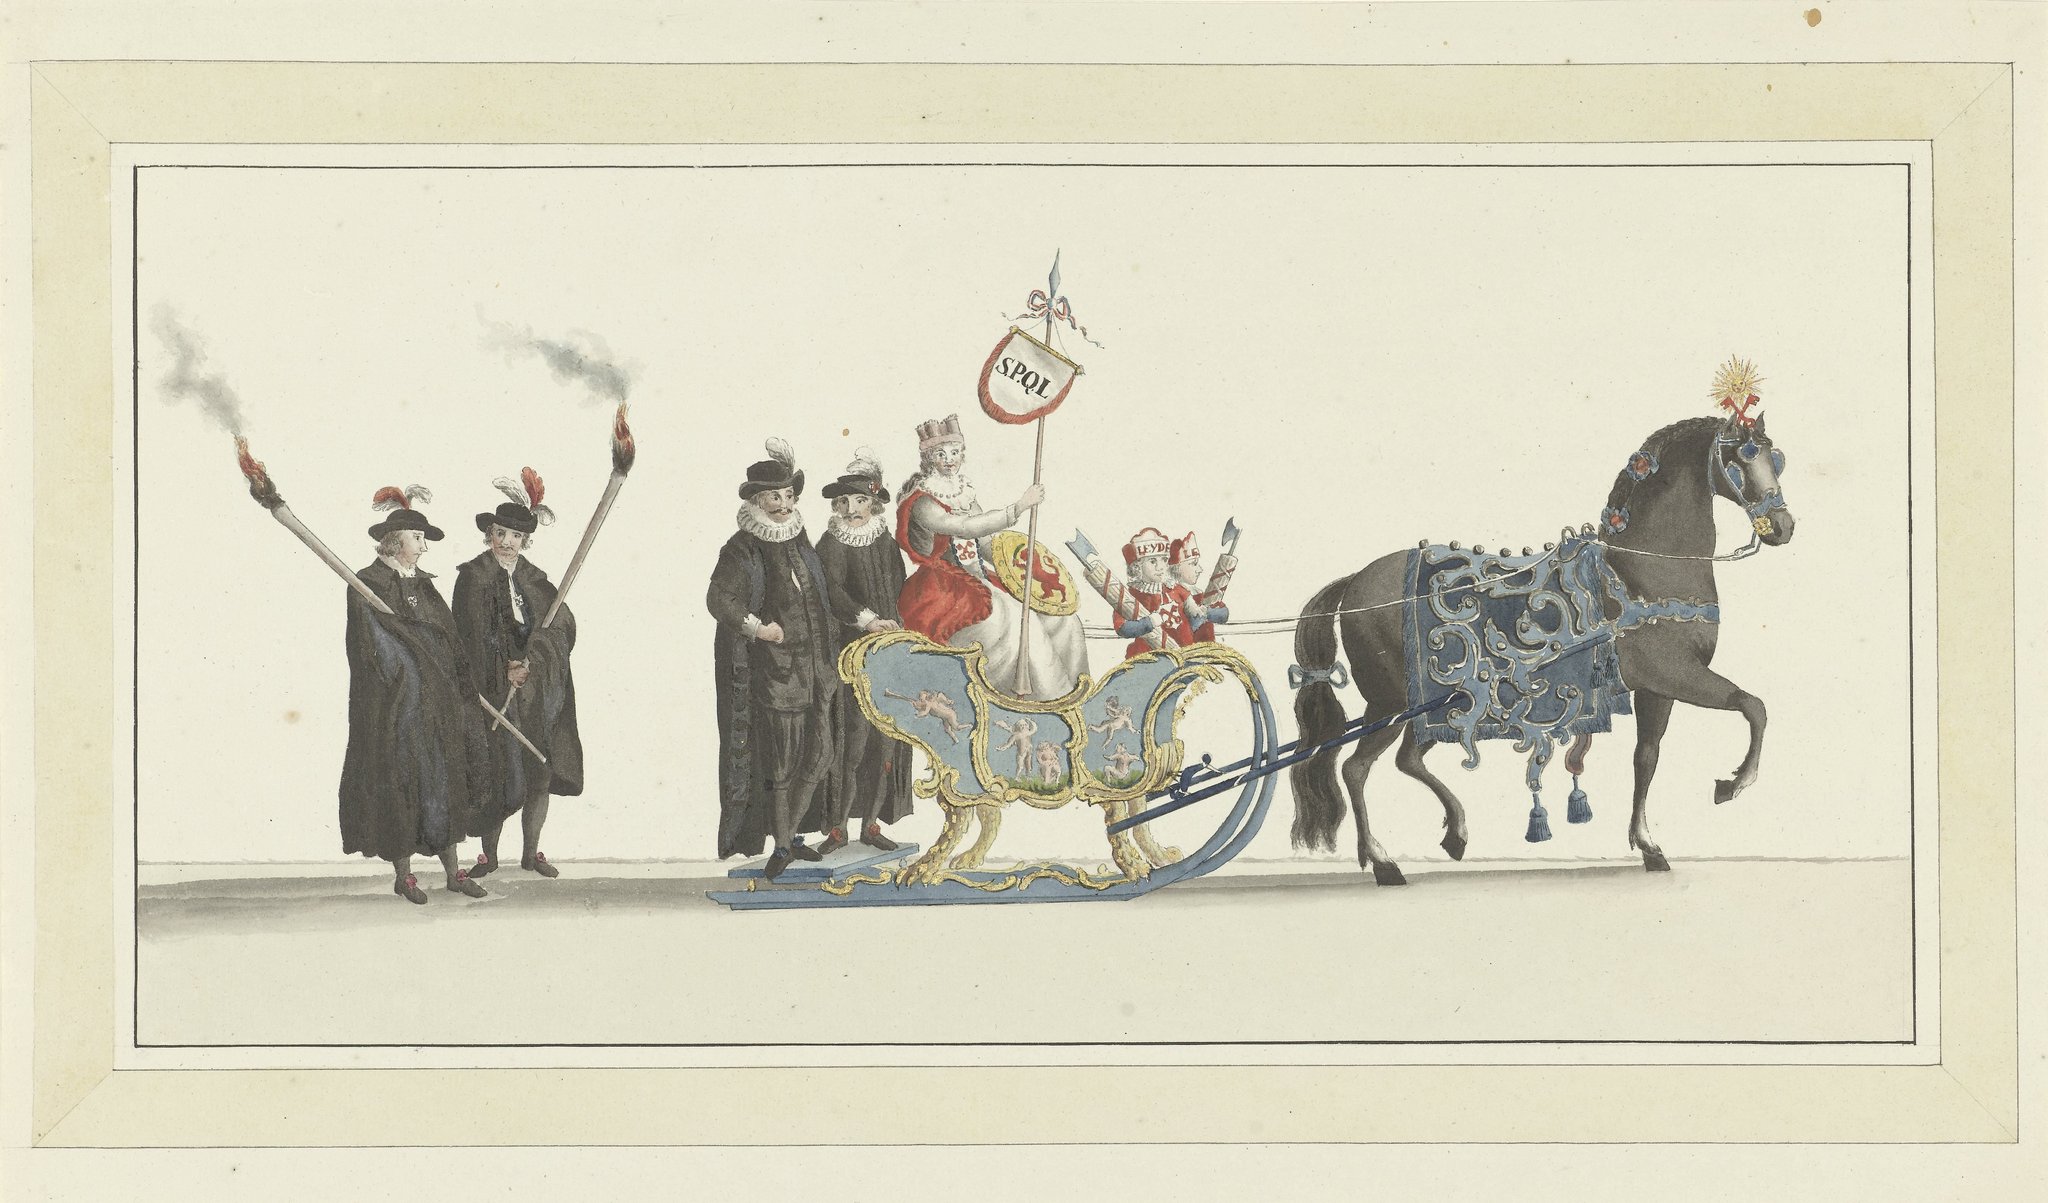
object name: drawing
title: Plegtige Sledevaert, Betrekkelijk de beide tweede Eeuwfeesten der Stad Leyden, en de Stichtinge van 's Lands Hooge Schoole aldaer, door het Tooneelgenootschap onder de spreuk: Veniam Pro Laude, Gehouden op den XXIV van Louwmaand 1776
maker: abraham delfos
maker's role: draughtsman, painter, print maker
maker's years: 1731-1820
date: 1776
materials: paper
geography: northern netherlands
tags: personification of a city, town-patron(ess), sledge, sleigh (winter sports), commemoration of the founding of a university, leiden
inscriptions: collector's mark: Lugt 2228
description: De zesde slede in de optocht. Een slede met de stadsmaagd van Leiden, getrokken door een paard en gevolgd door twee stadsboden te voet. Onderdeel van de reeks van vijftien tekeningen voor de platen van de sledevaart op 24 januari 1776 georganiseerd door het Leidse genootschap Veniam Pro Laude bij gelegenheid van het Tweede Eeuwfeest van het Leids Ontzet (3 oktober 1574) en de oprichting van de Universiteit van Leiden (8 februari 1575).